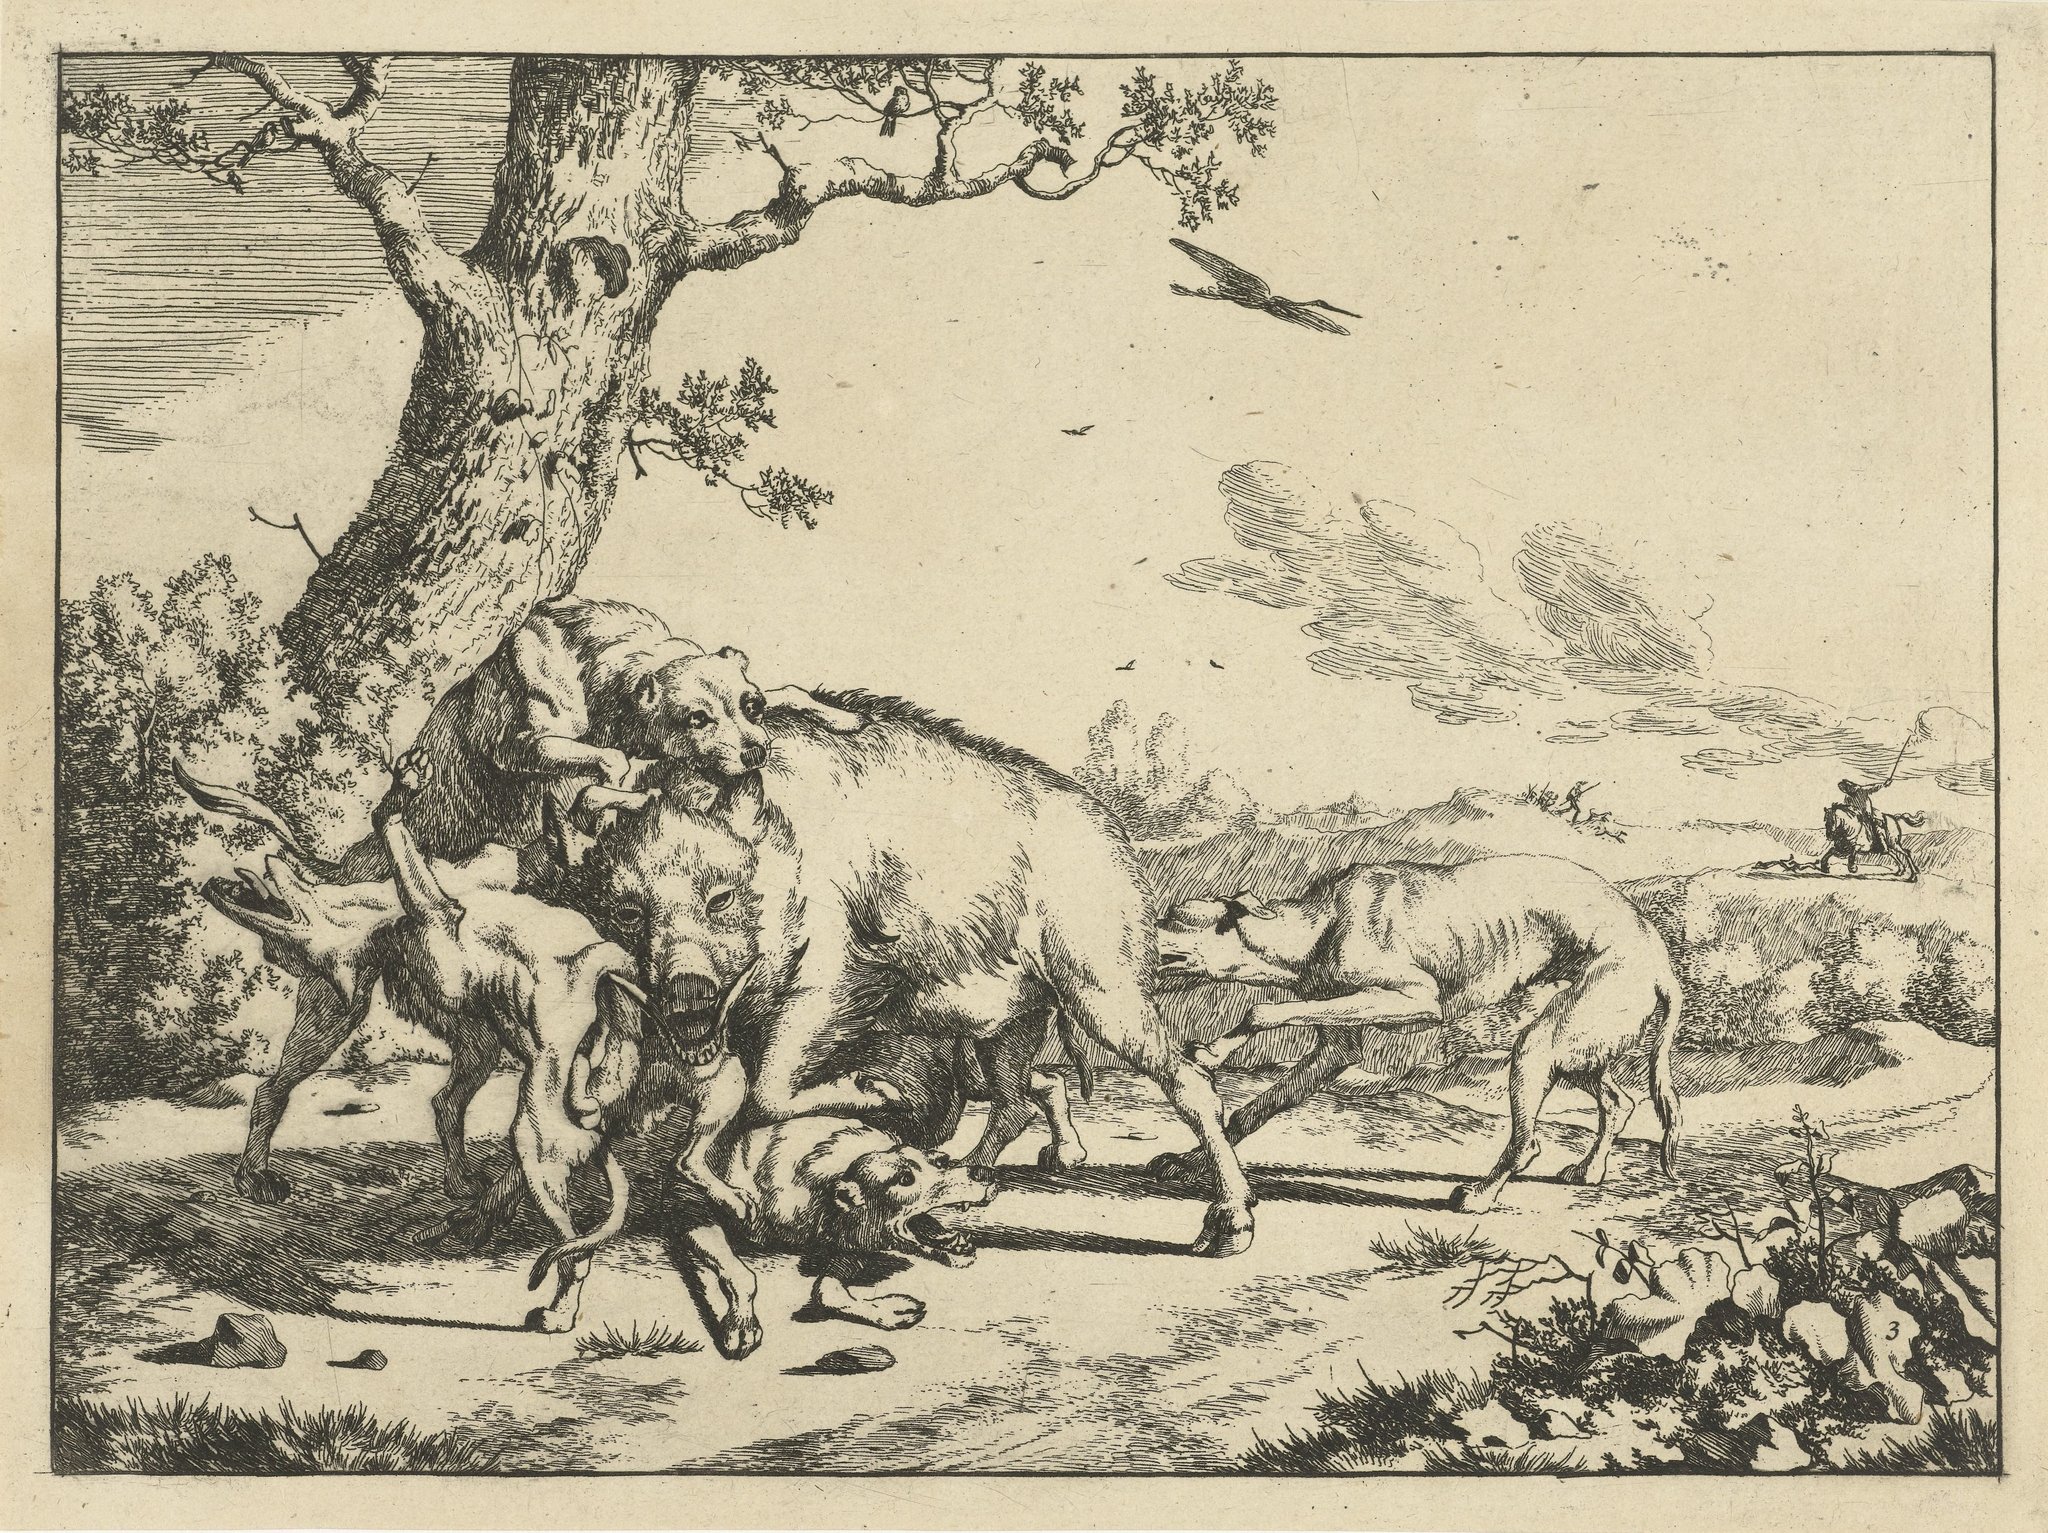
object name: print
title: Zwijn aangevallen door vier jachthonden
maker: marcus de bye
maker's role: print maker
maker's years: 1639-1688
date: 1657-1677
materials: paper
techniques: etching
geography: the hague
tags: hunting, chase, hunting dogs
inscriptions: collector's mark: Lugt 2228